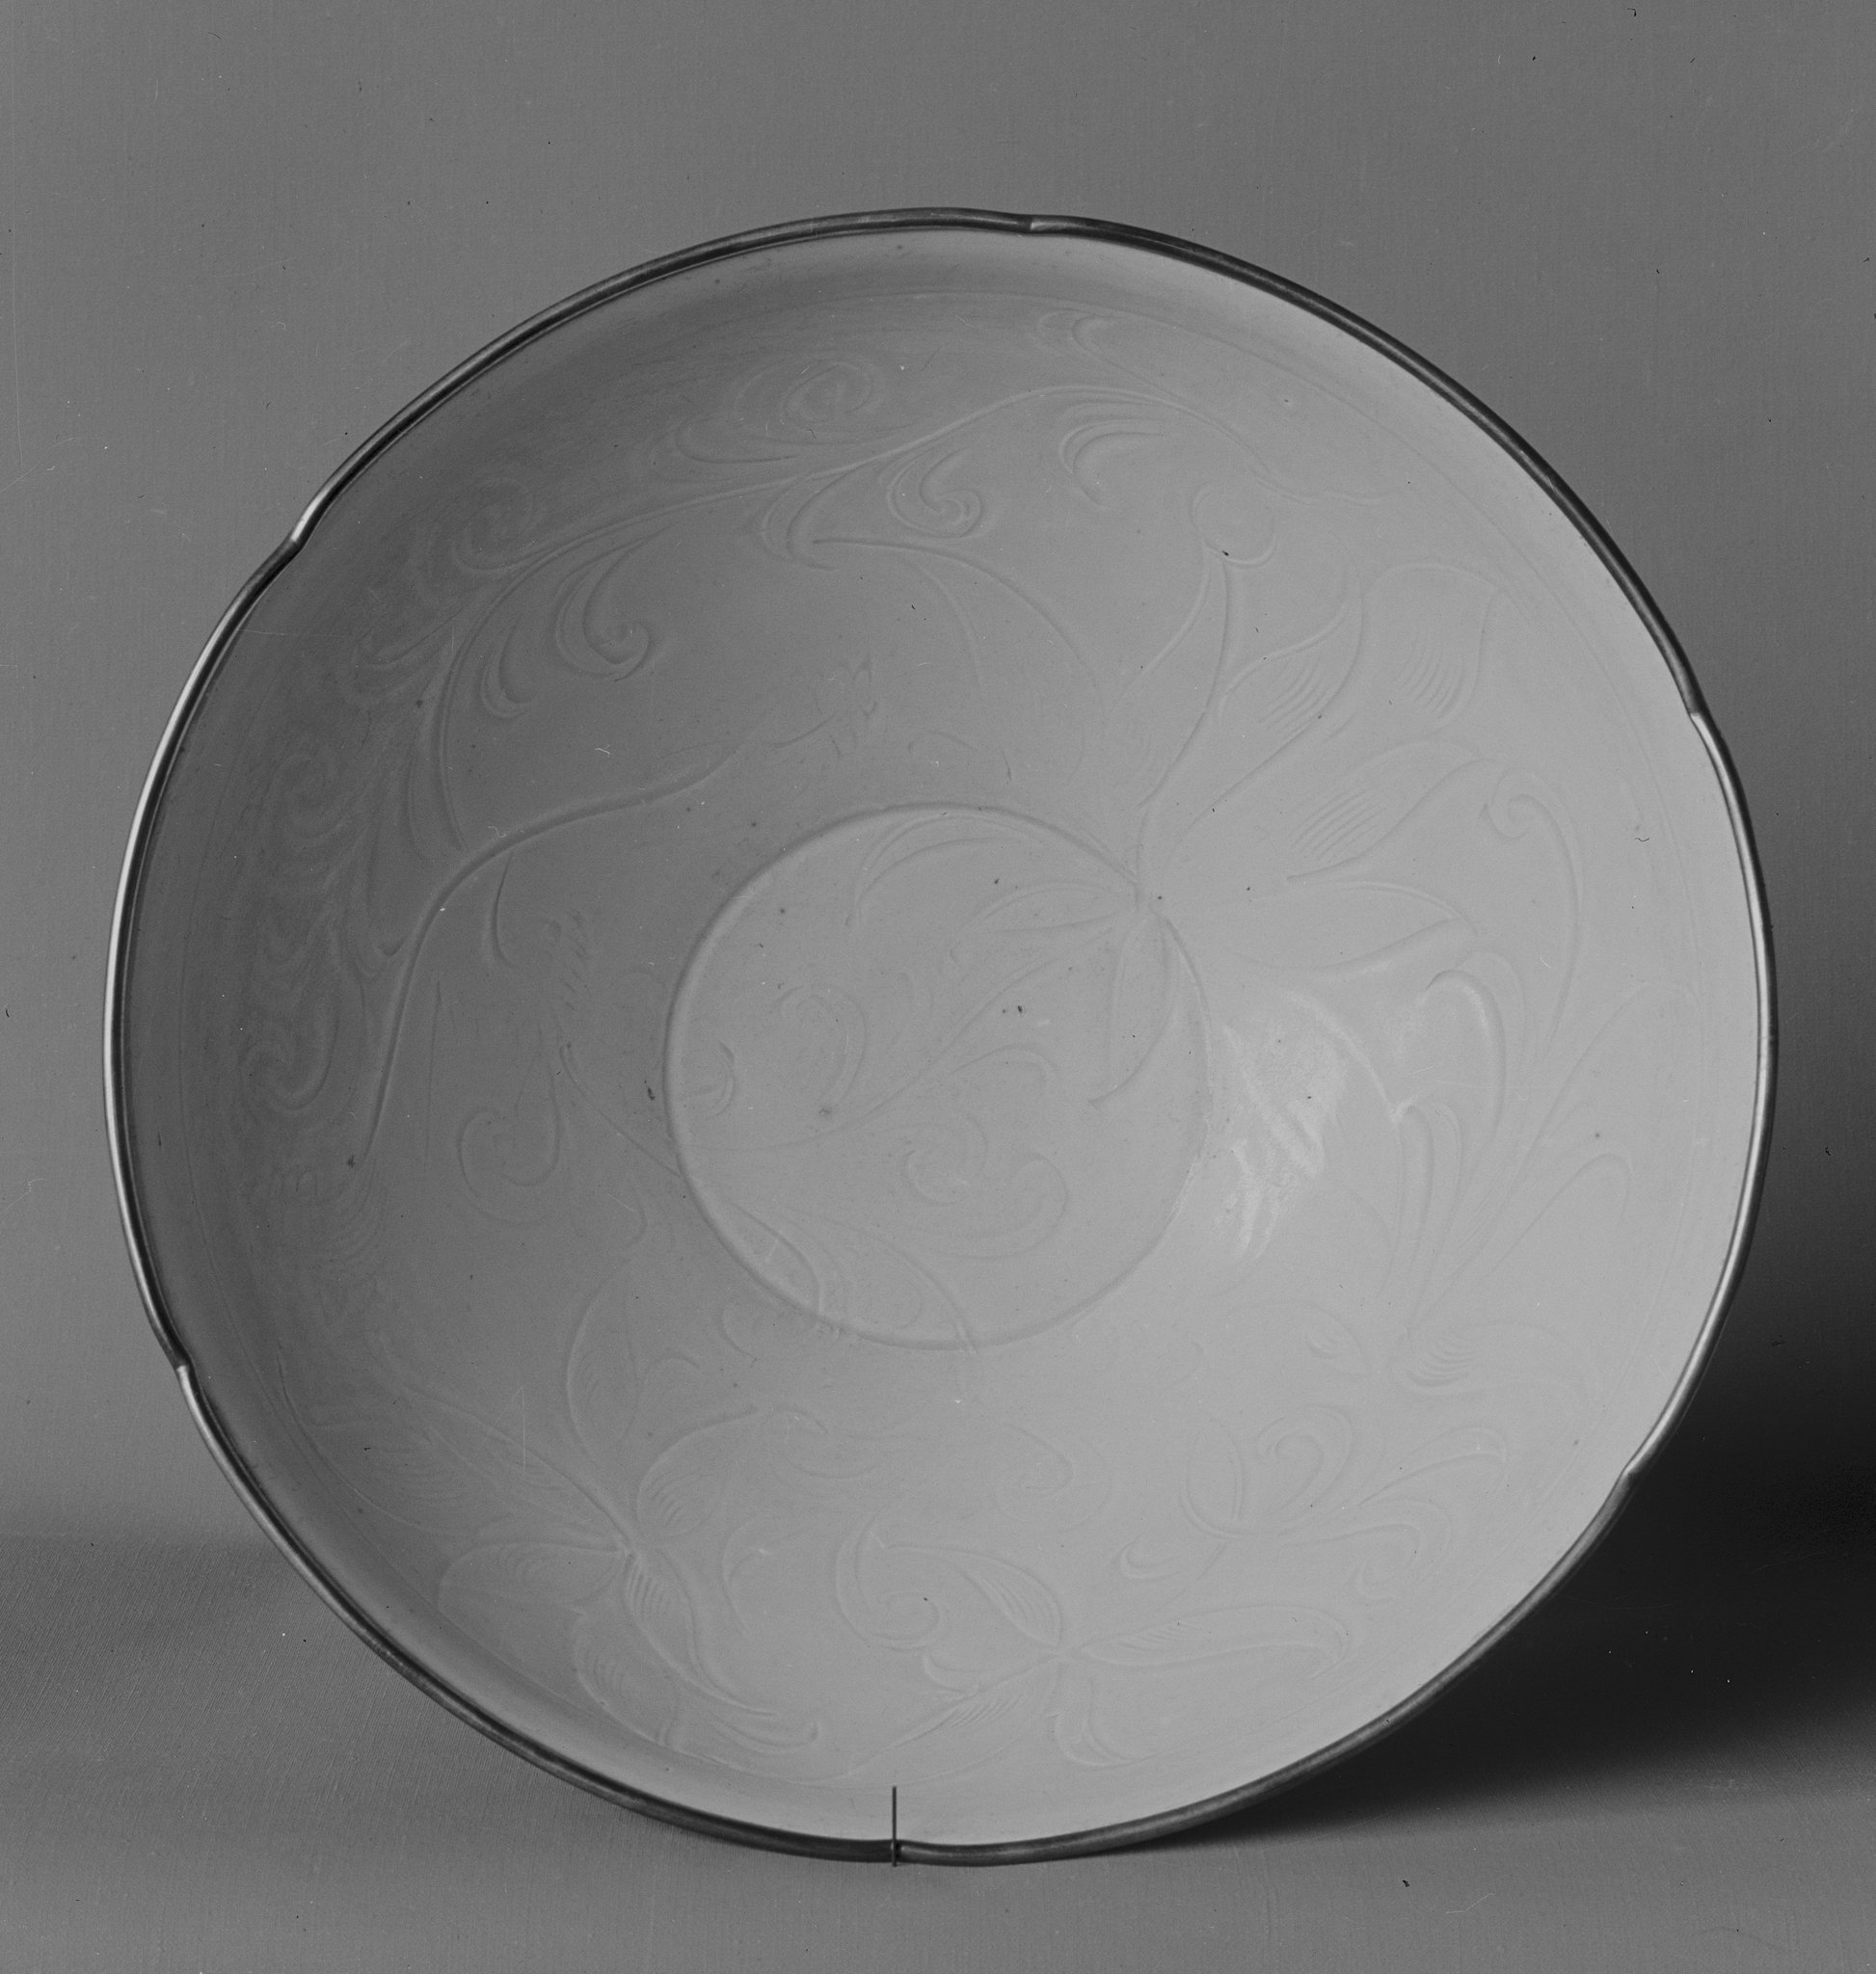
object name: bowl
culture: chinese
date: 1001-1200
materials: glaze, ivory, porcelain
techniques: incising